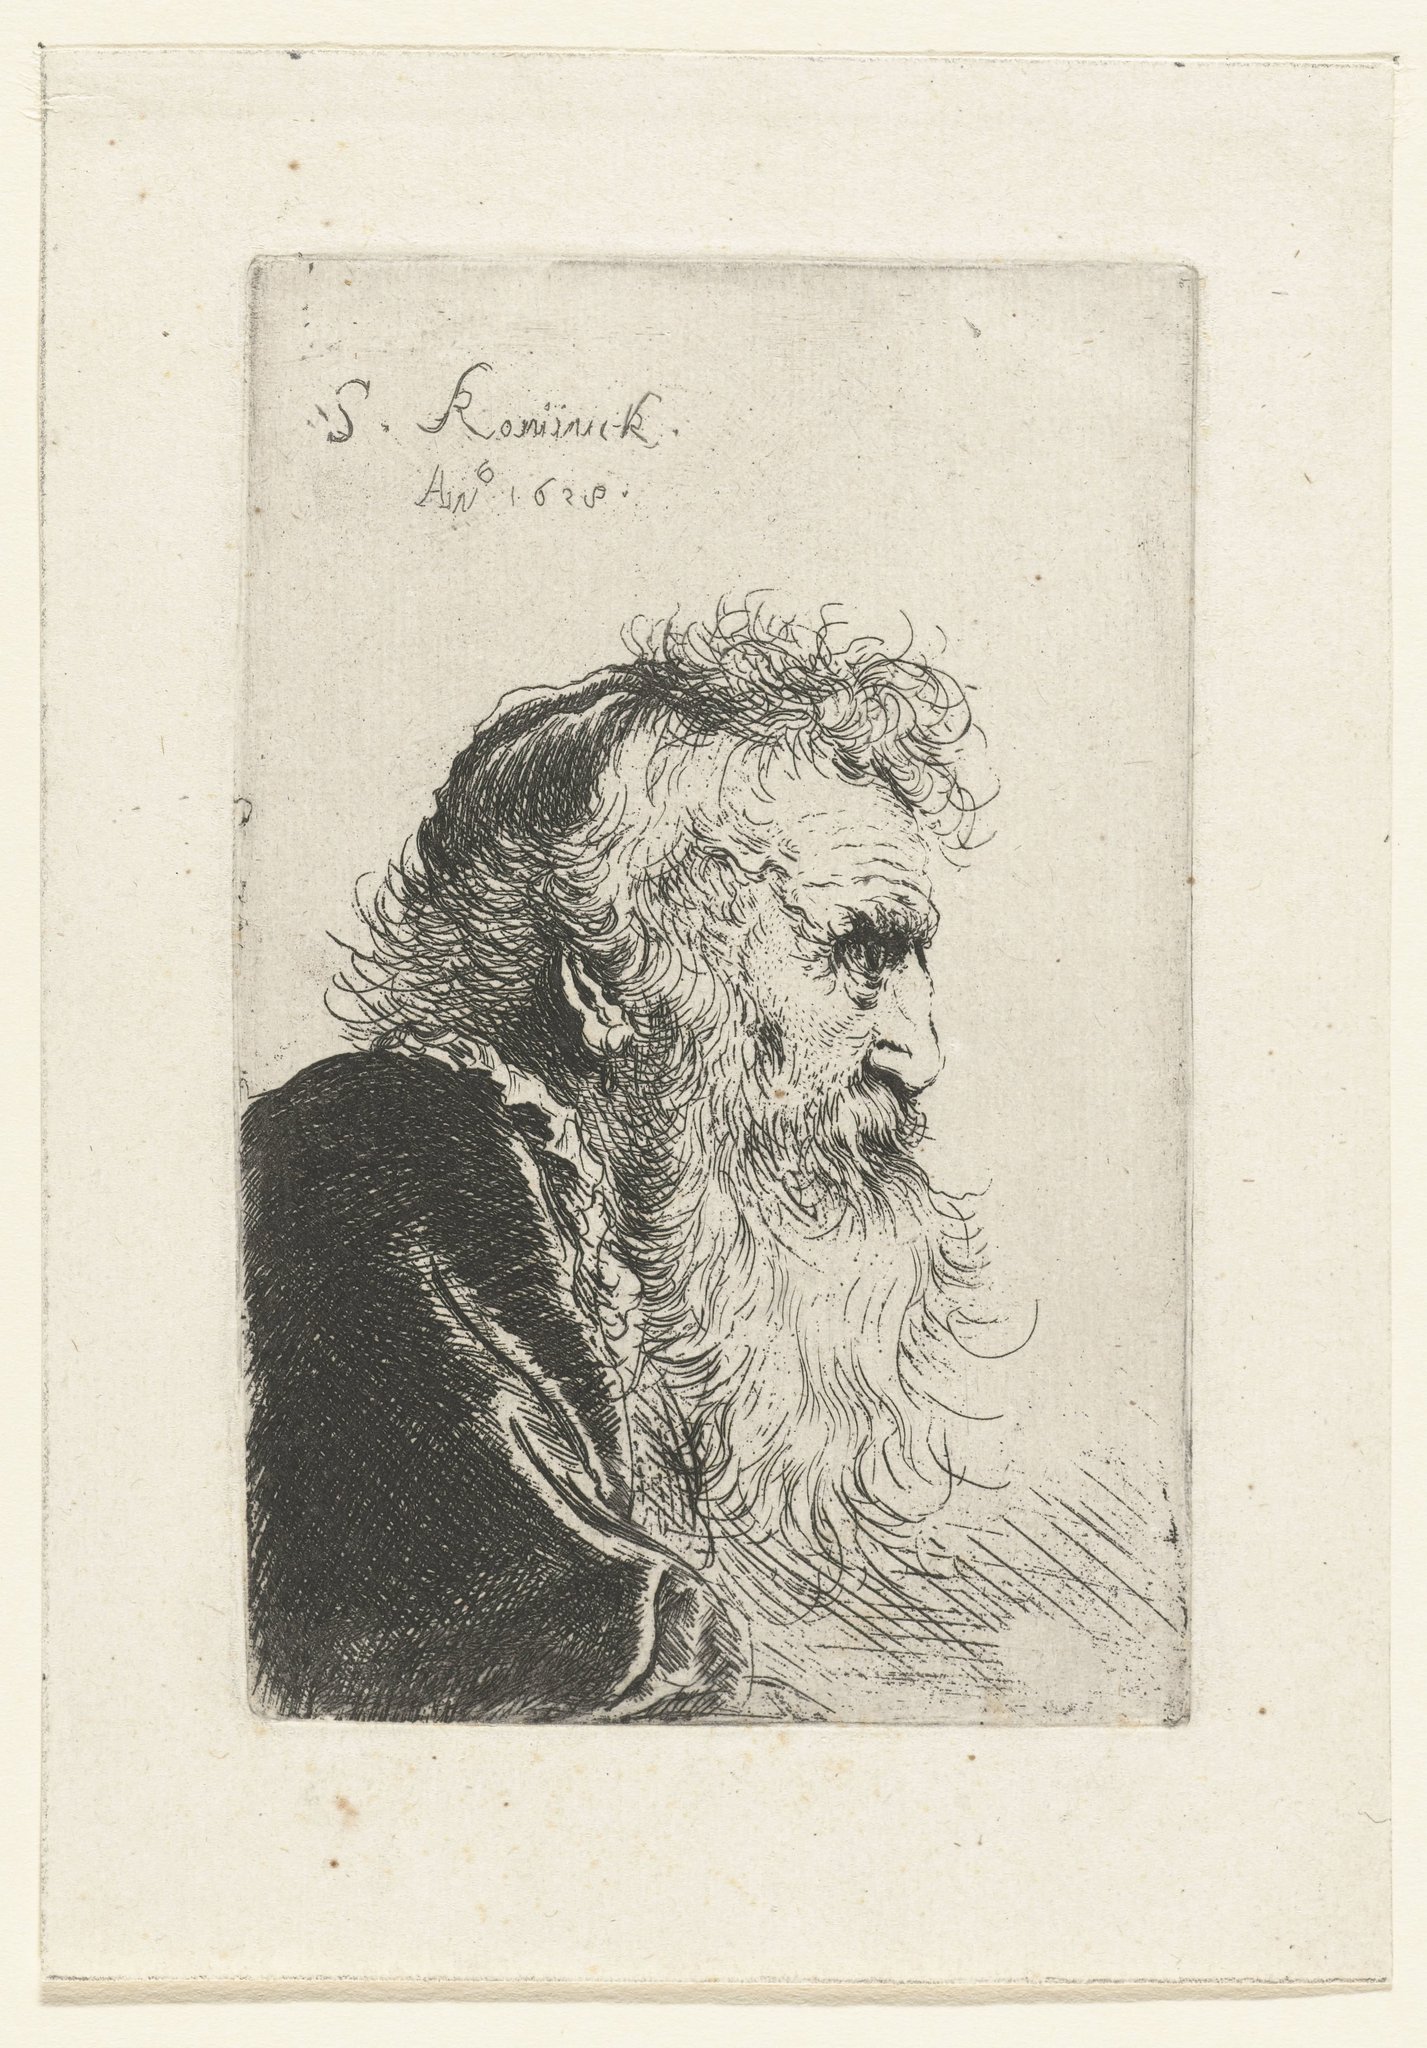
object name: print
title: Oude man met baard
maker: salomon koninck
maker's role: draughtsman, painter, print maker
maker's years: 1609-1656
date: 1628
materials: paper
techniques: etching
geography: netherlands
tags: old man (+ sideview, profile)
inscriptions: collector's mark: Lugt 240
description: Hoofd van een oude man met baard en profil.